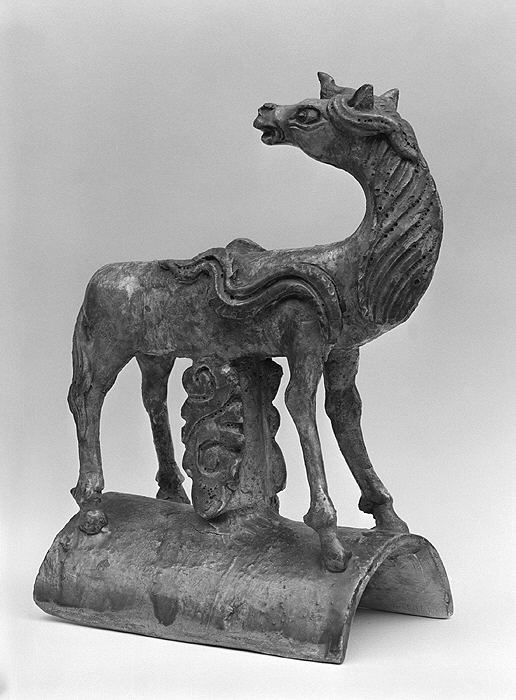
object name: roof tile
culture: chinese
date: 1801-1900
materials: pottery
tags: animals